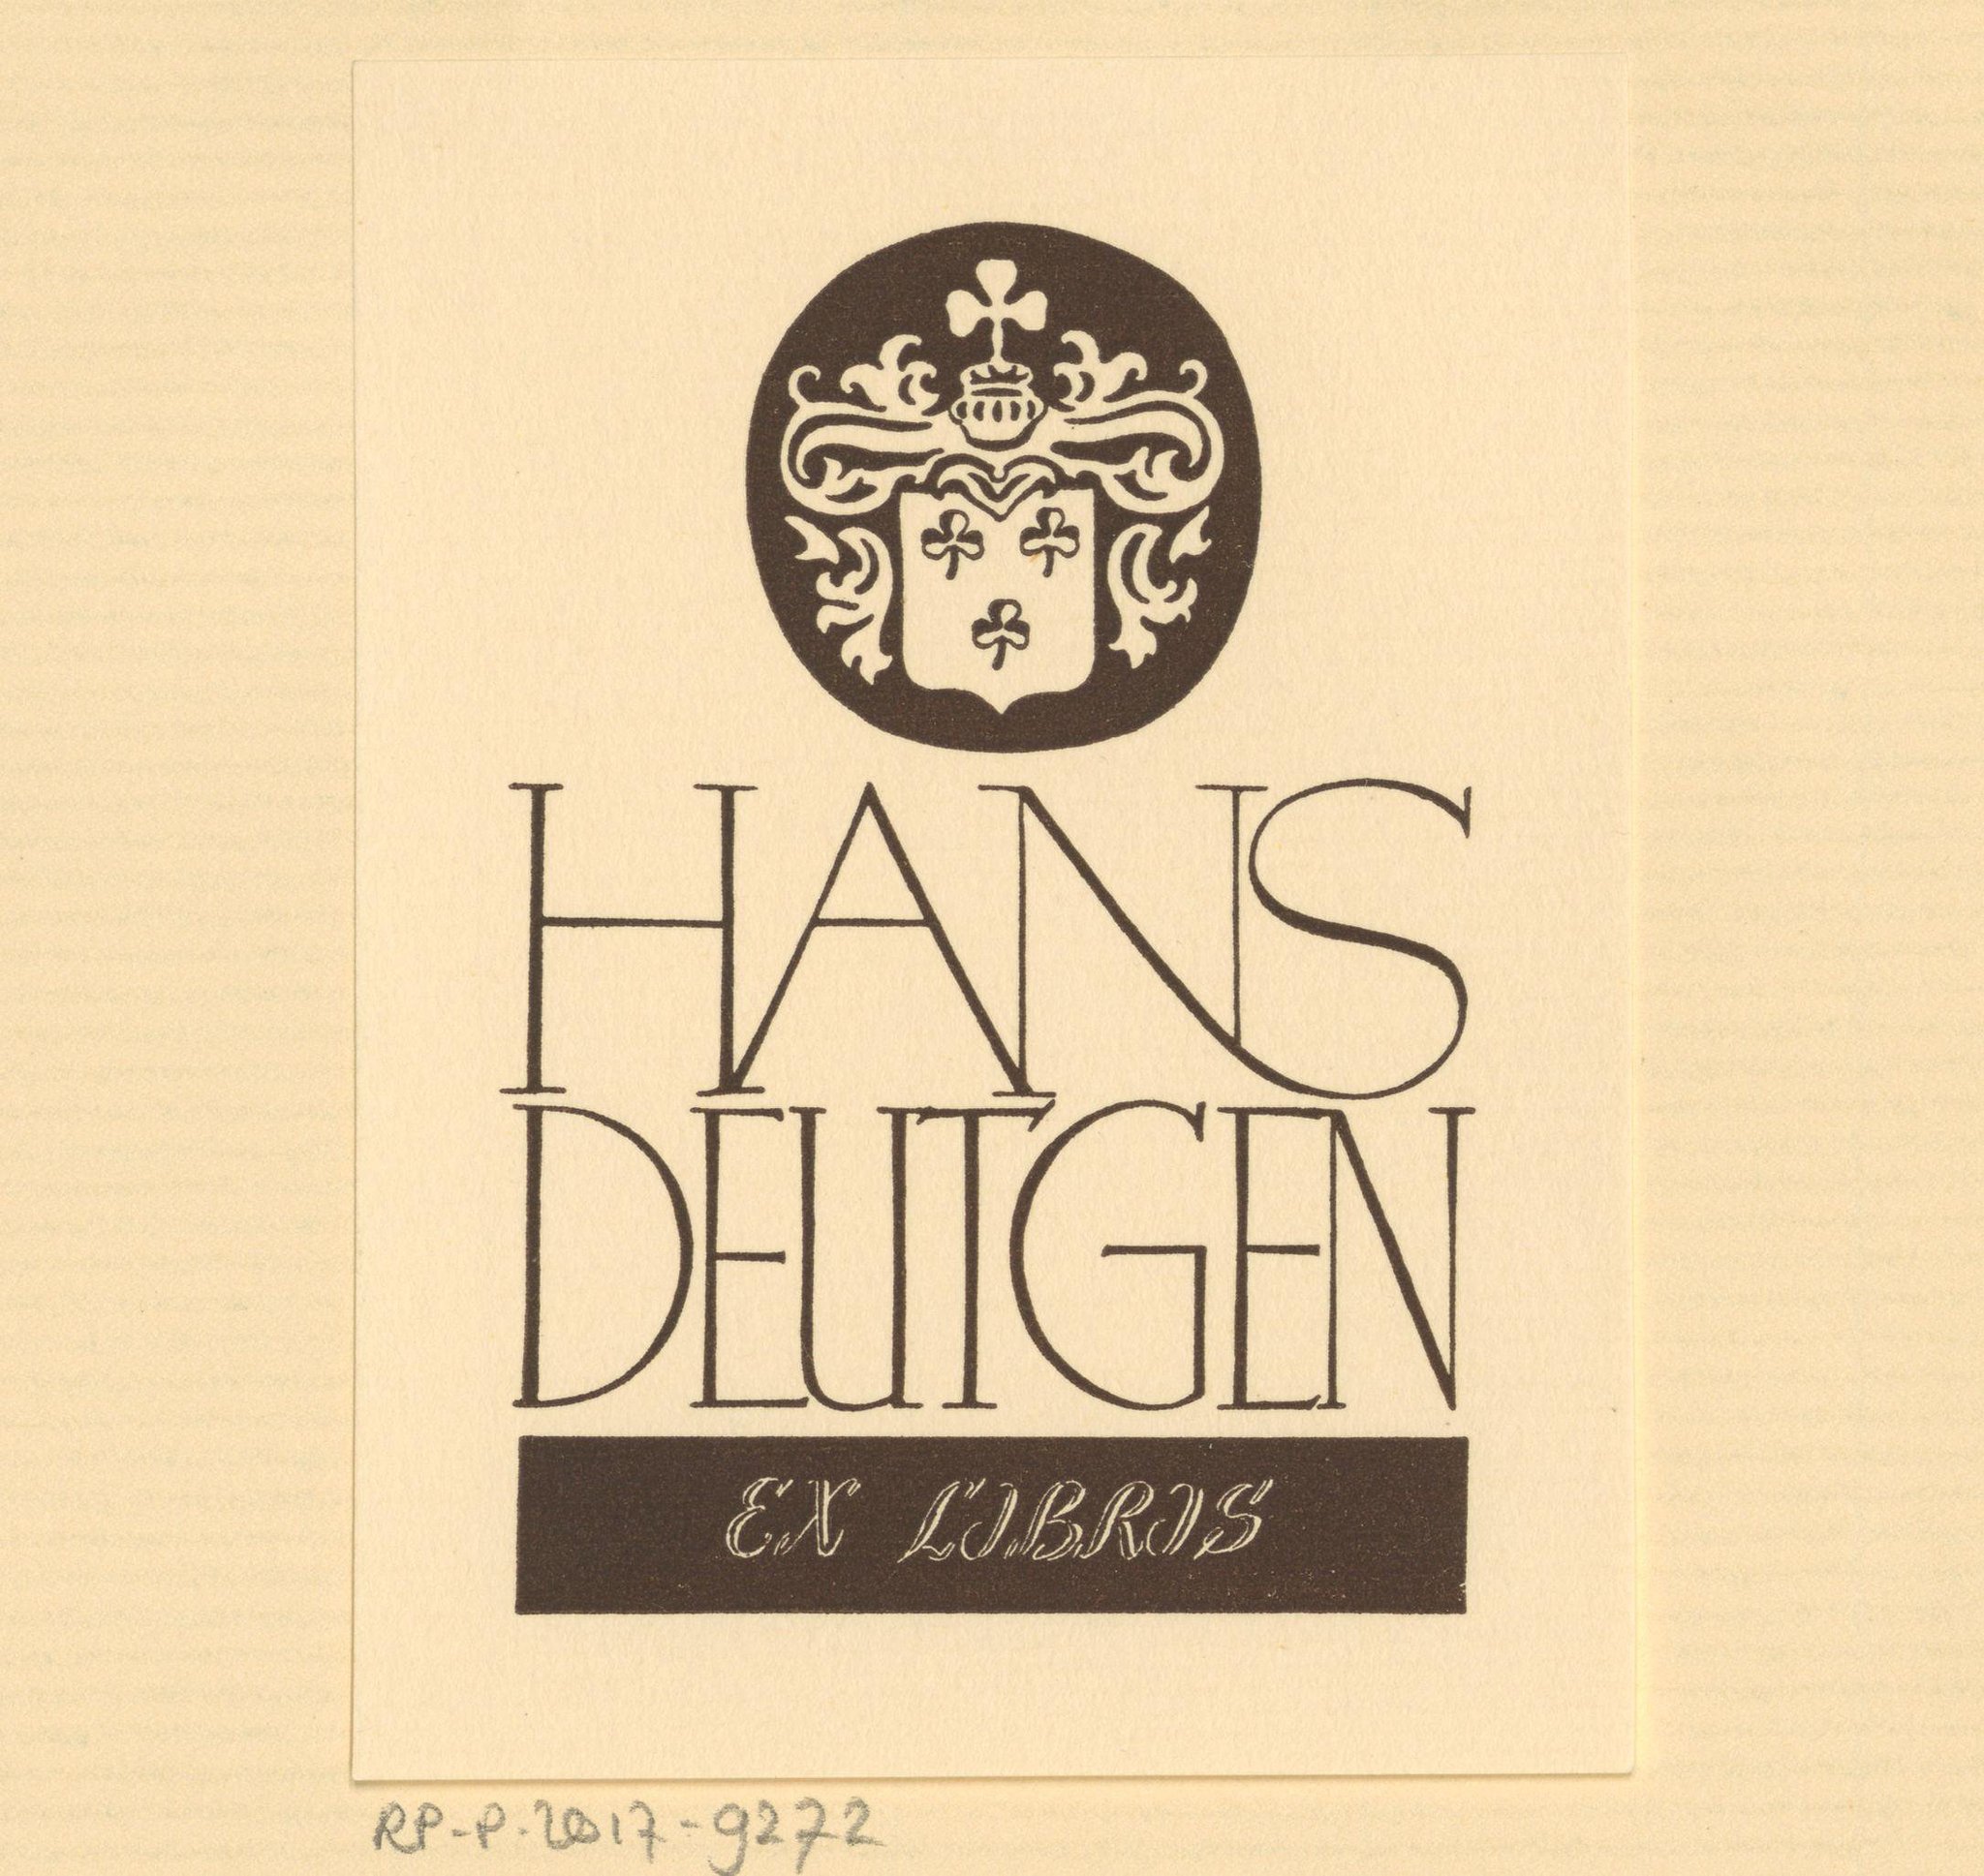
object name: bookplate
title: Ex libris van Hans Deutgen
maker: Anonymous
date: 1927-1989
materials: paper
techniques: printing block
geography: france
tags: armorial bearing, heraldry